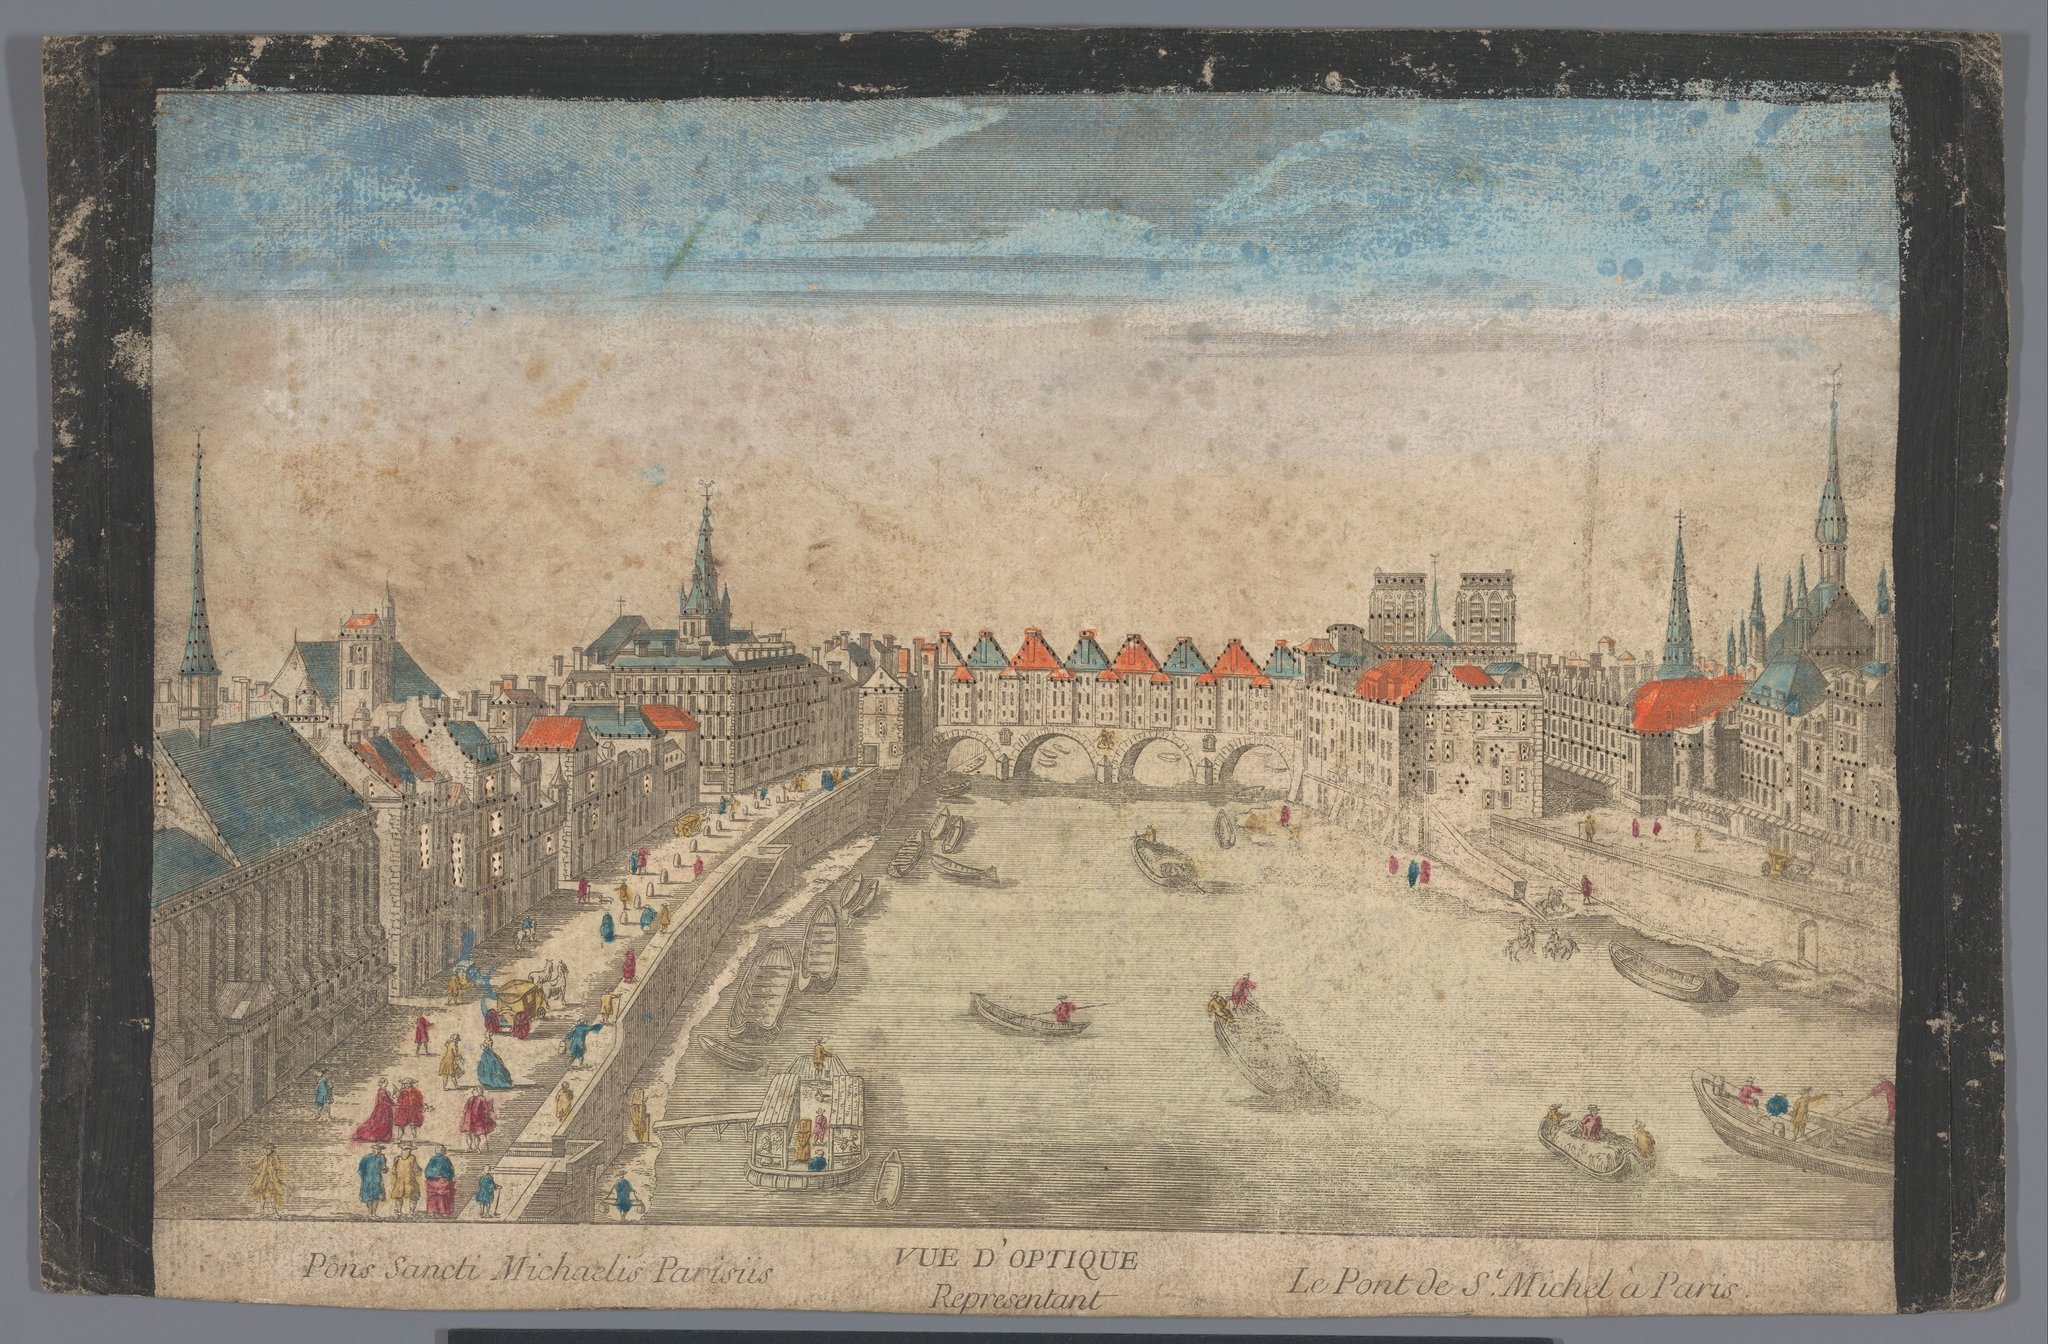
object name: print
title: Vue d'optique representant le Pont de St. Michel à Paris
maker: Anonymous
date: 1700-1799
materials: cardboard, paint, paper, watercolor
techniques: brush, cutting, etching, perforating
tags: bridge in city across river, canal, etc. (+ city(-scape) with figures, staffage), rowing-boat, canoe, etc.